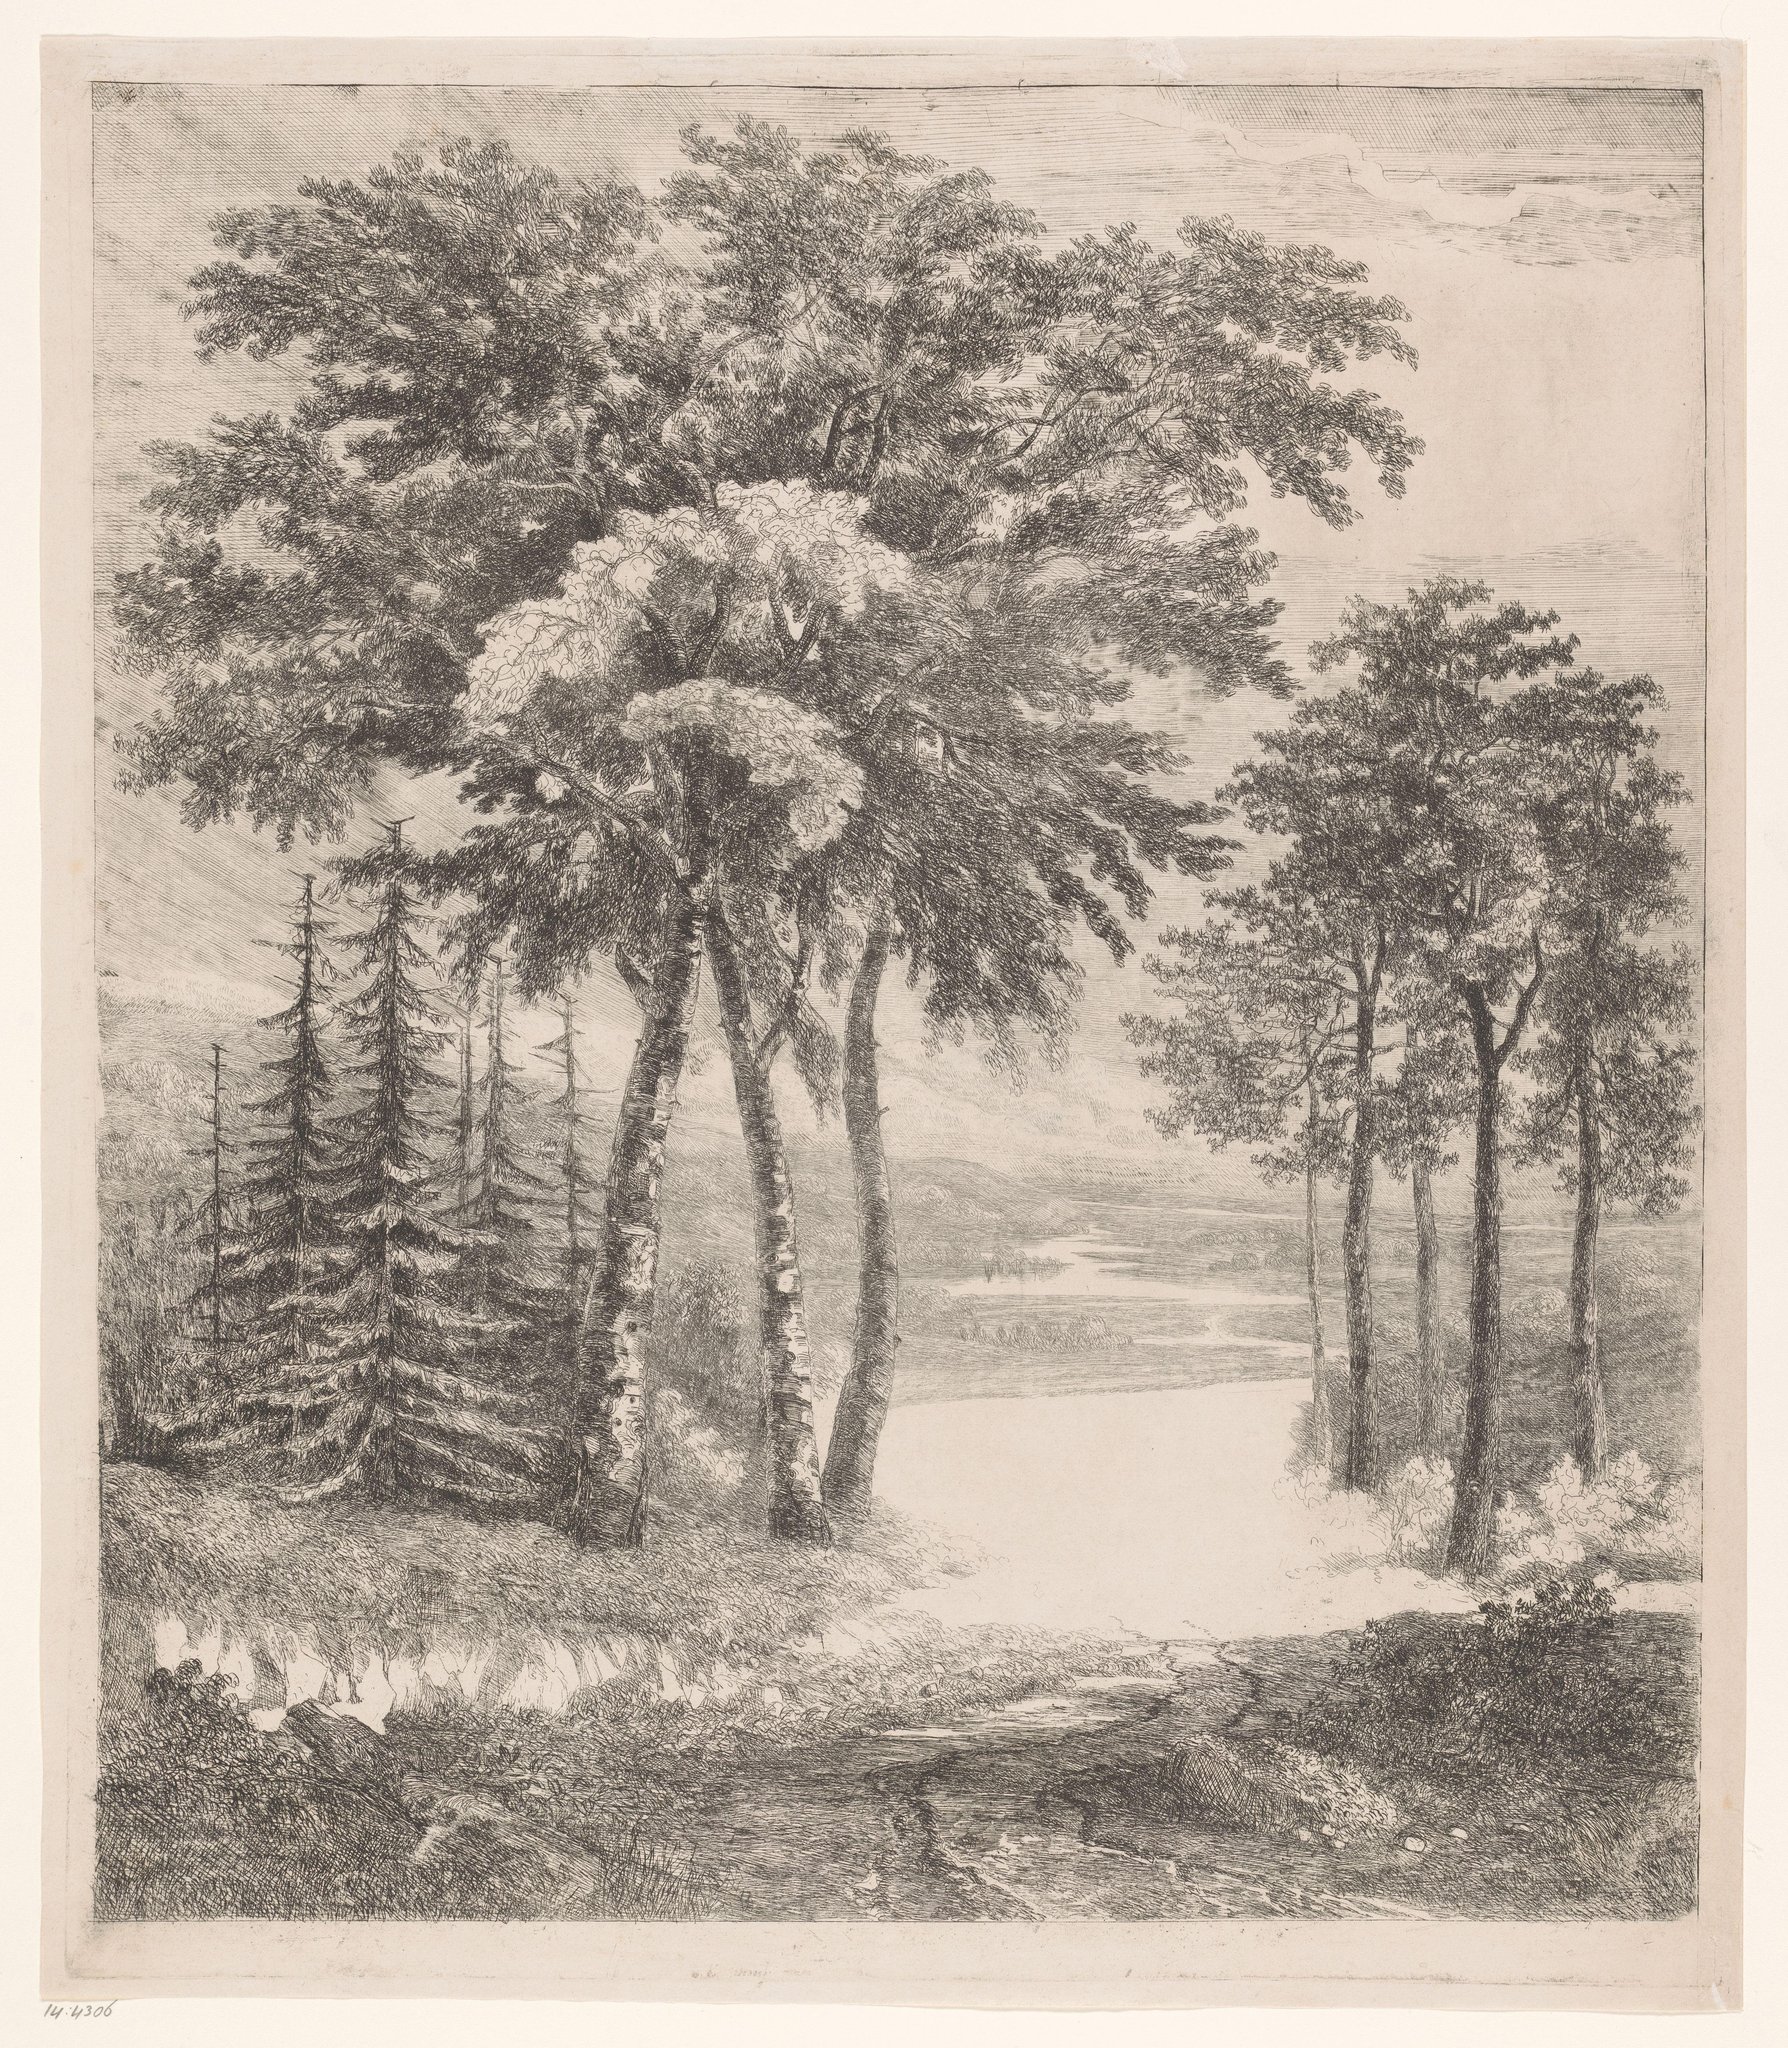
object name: print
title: Landschap met paardenkar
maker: jean théodore joseph linnig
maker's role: draughtsman, print maker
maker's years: 1815-1891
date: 1825-1891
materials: paper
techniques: etching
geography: belgium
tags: forest path or lane, two-wheeled vehicle drawn by one animal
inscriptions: collector's mark: Lugt 2228, annotation: ‘Le bois avec la chaville’, collector's mark: Lugt 1485